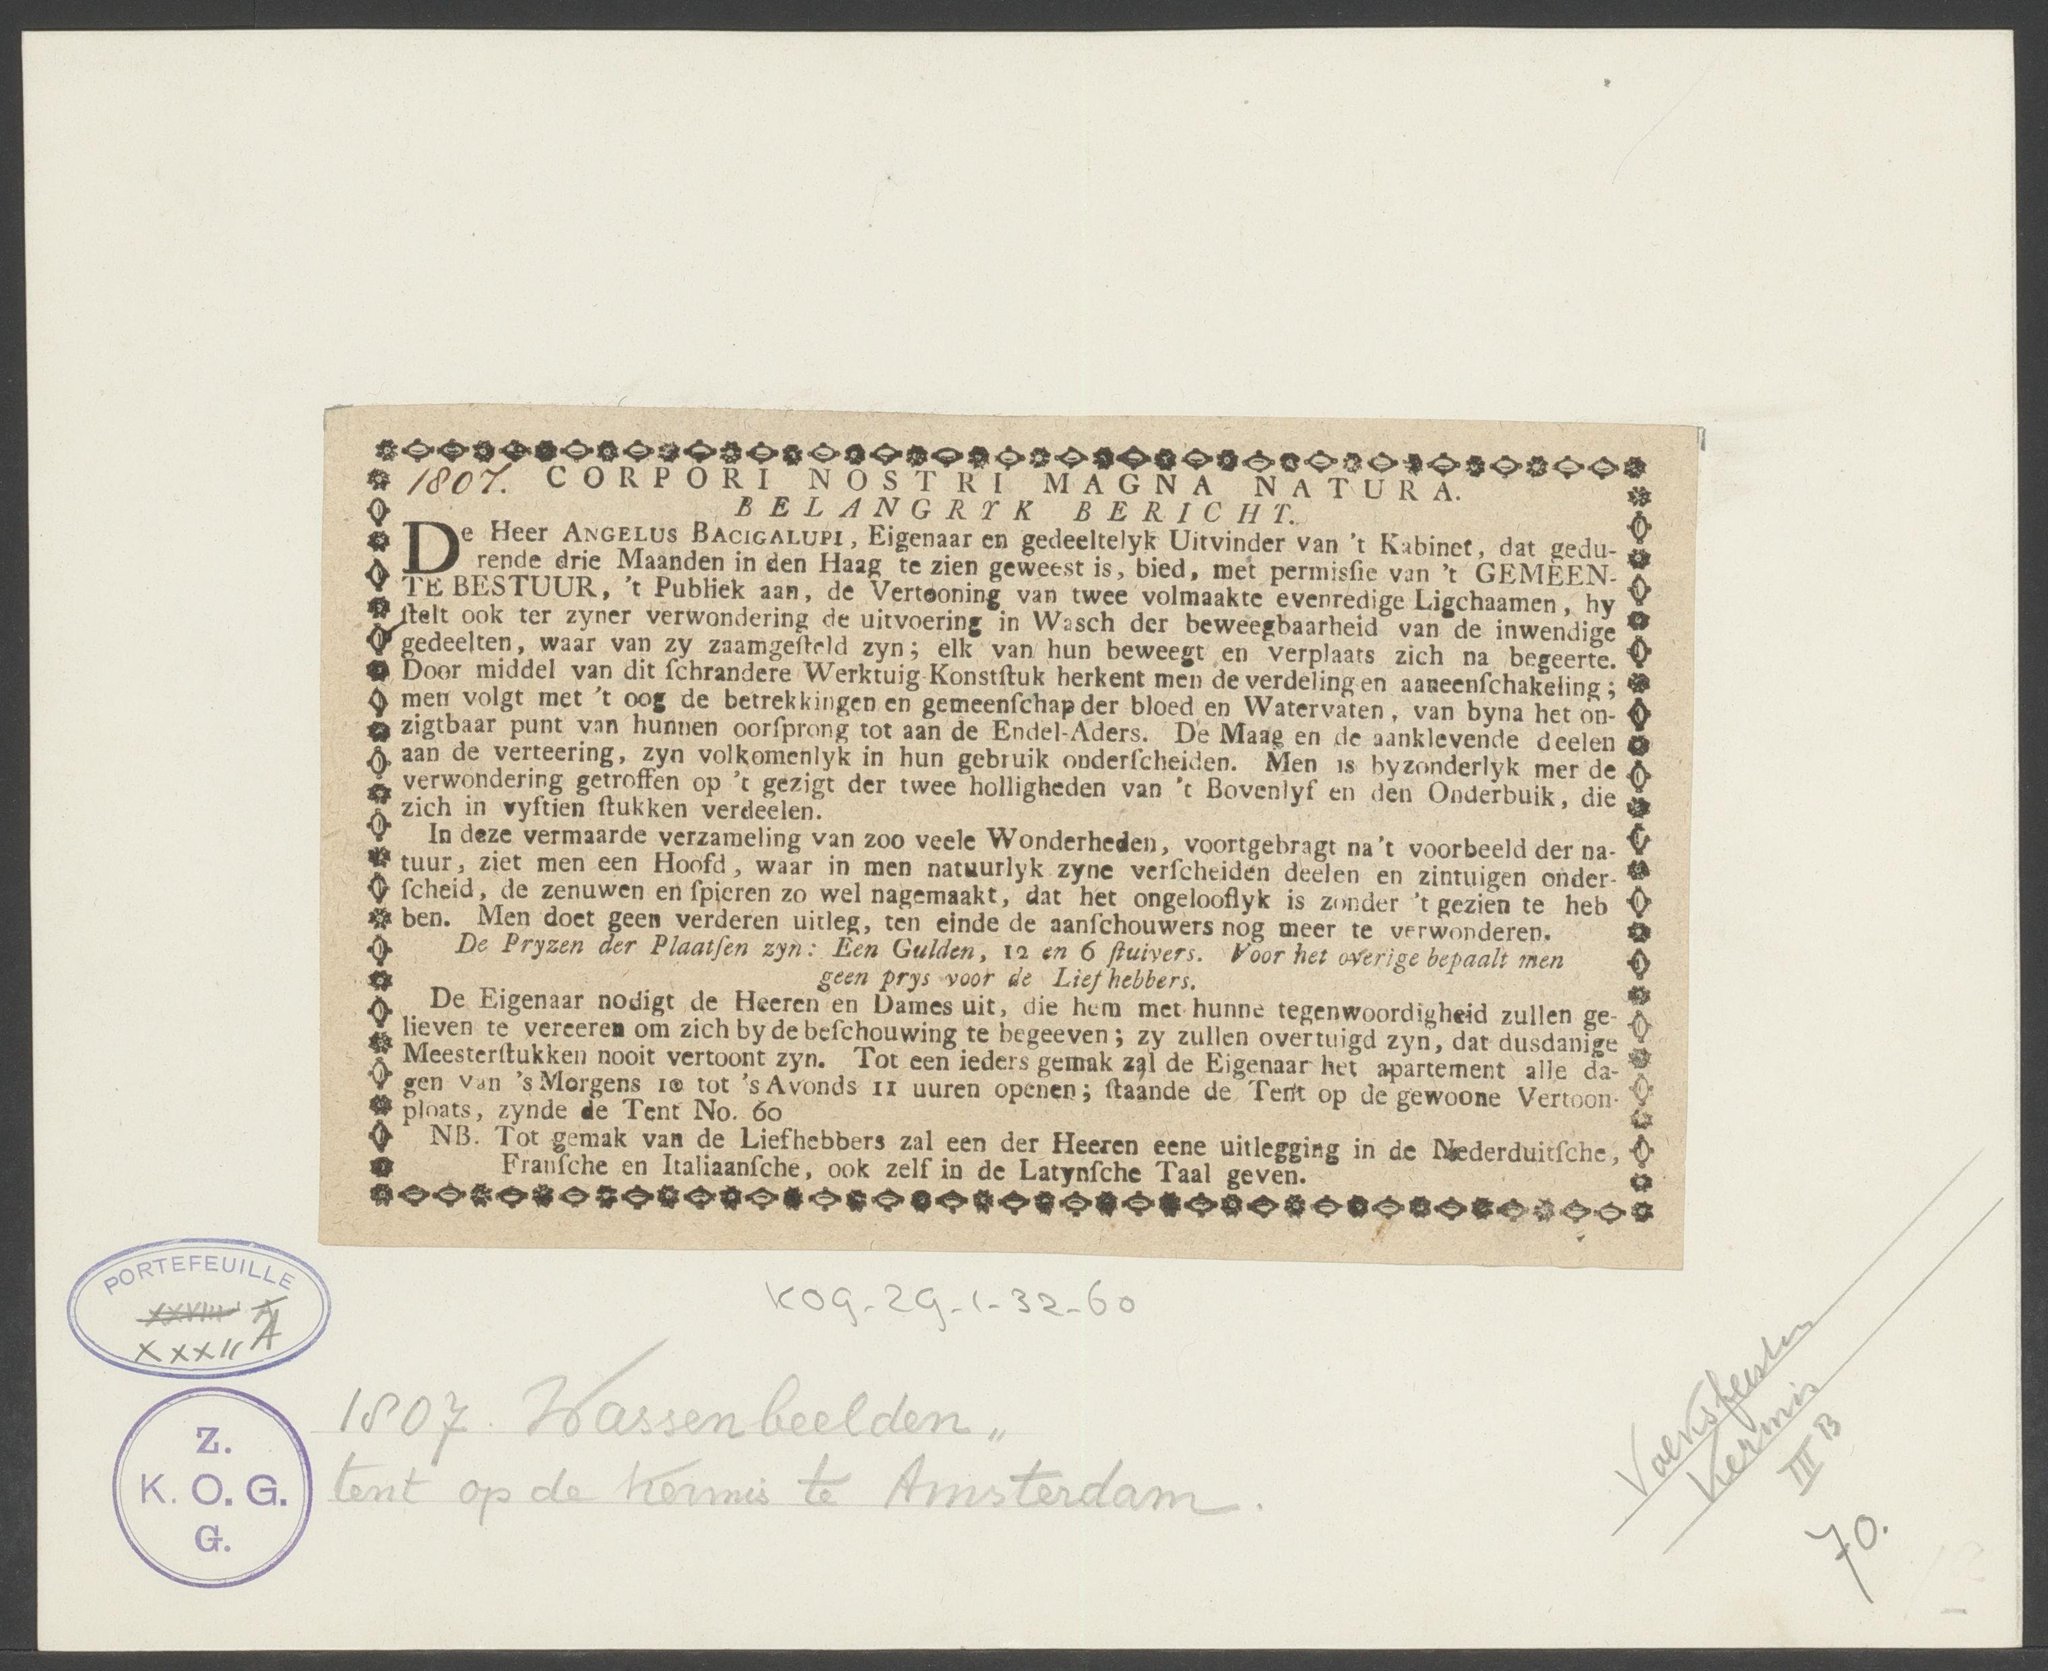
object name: reclamebiljet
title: Corpori Nostri Magna Natura / Belangryk Bericht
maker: Anonymous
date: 1807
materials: paper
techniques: letterpress printing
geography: netherlands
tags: wax-figure cabinet, pleasure fair and circus, amsterdam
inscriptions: collector's mark: Lugt 1641, collector's mark